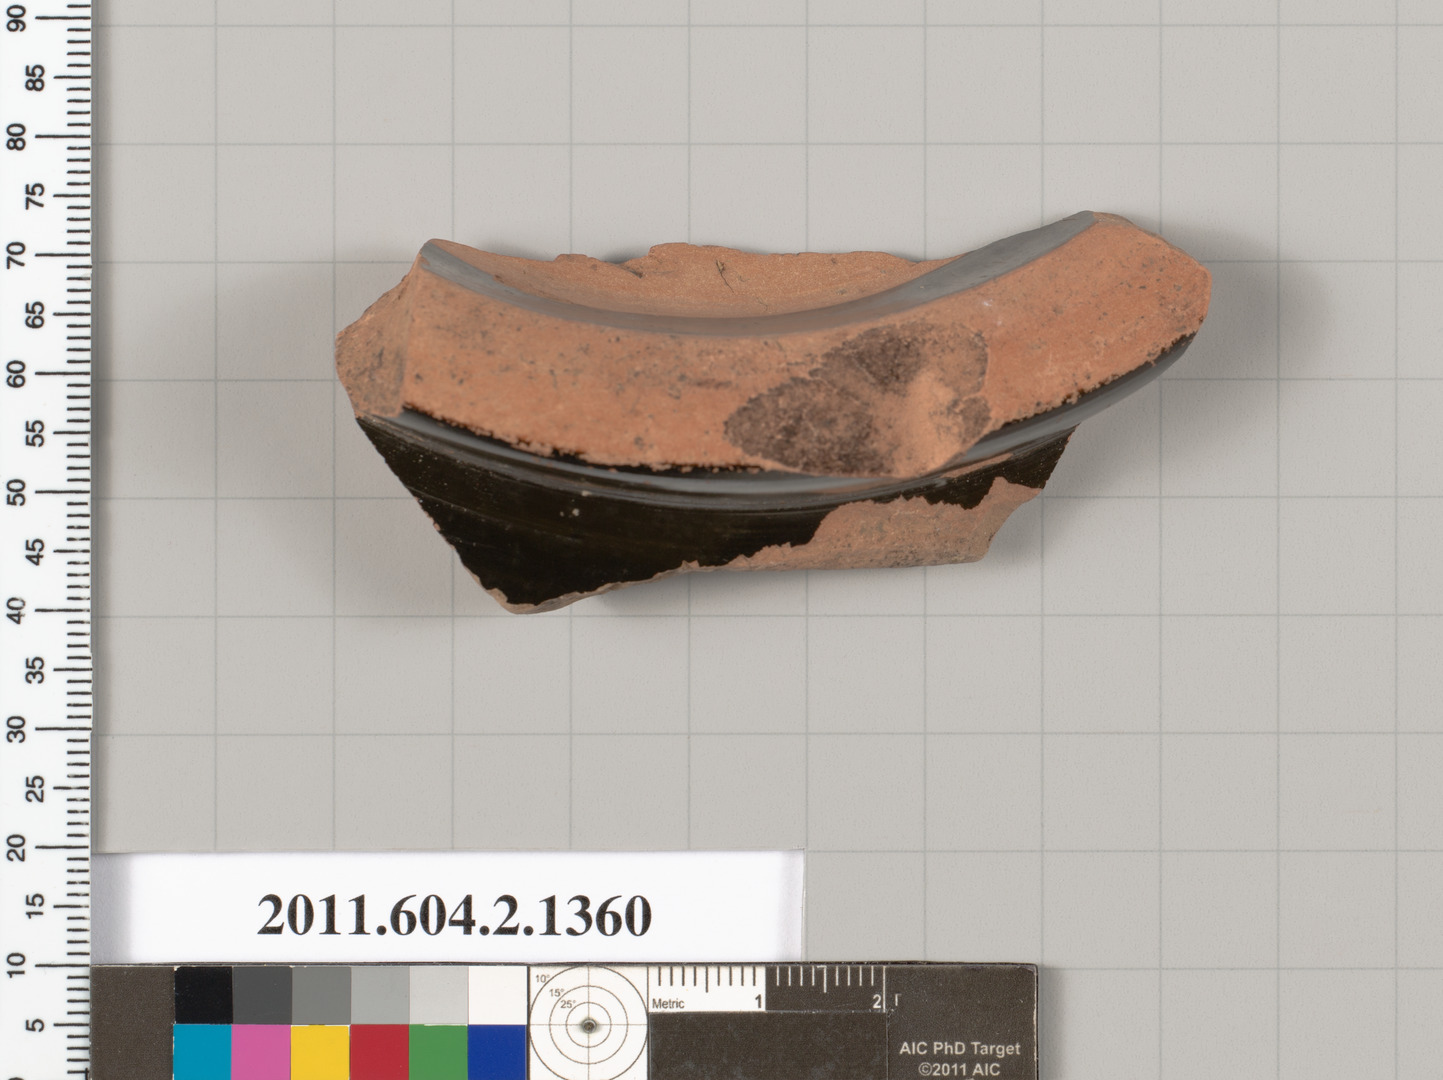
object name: skyphos fragment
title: Terracotta fragment of a skyphos (deep drinking cup)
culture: greek, attic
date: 475-451 BCE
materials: terracotta